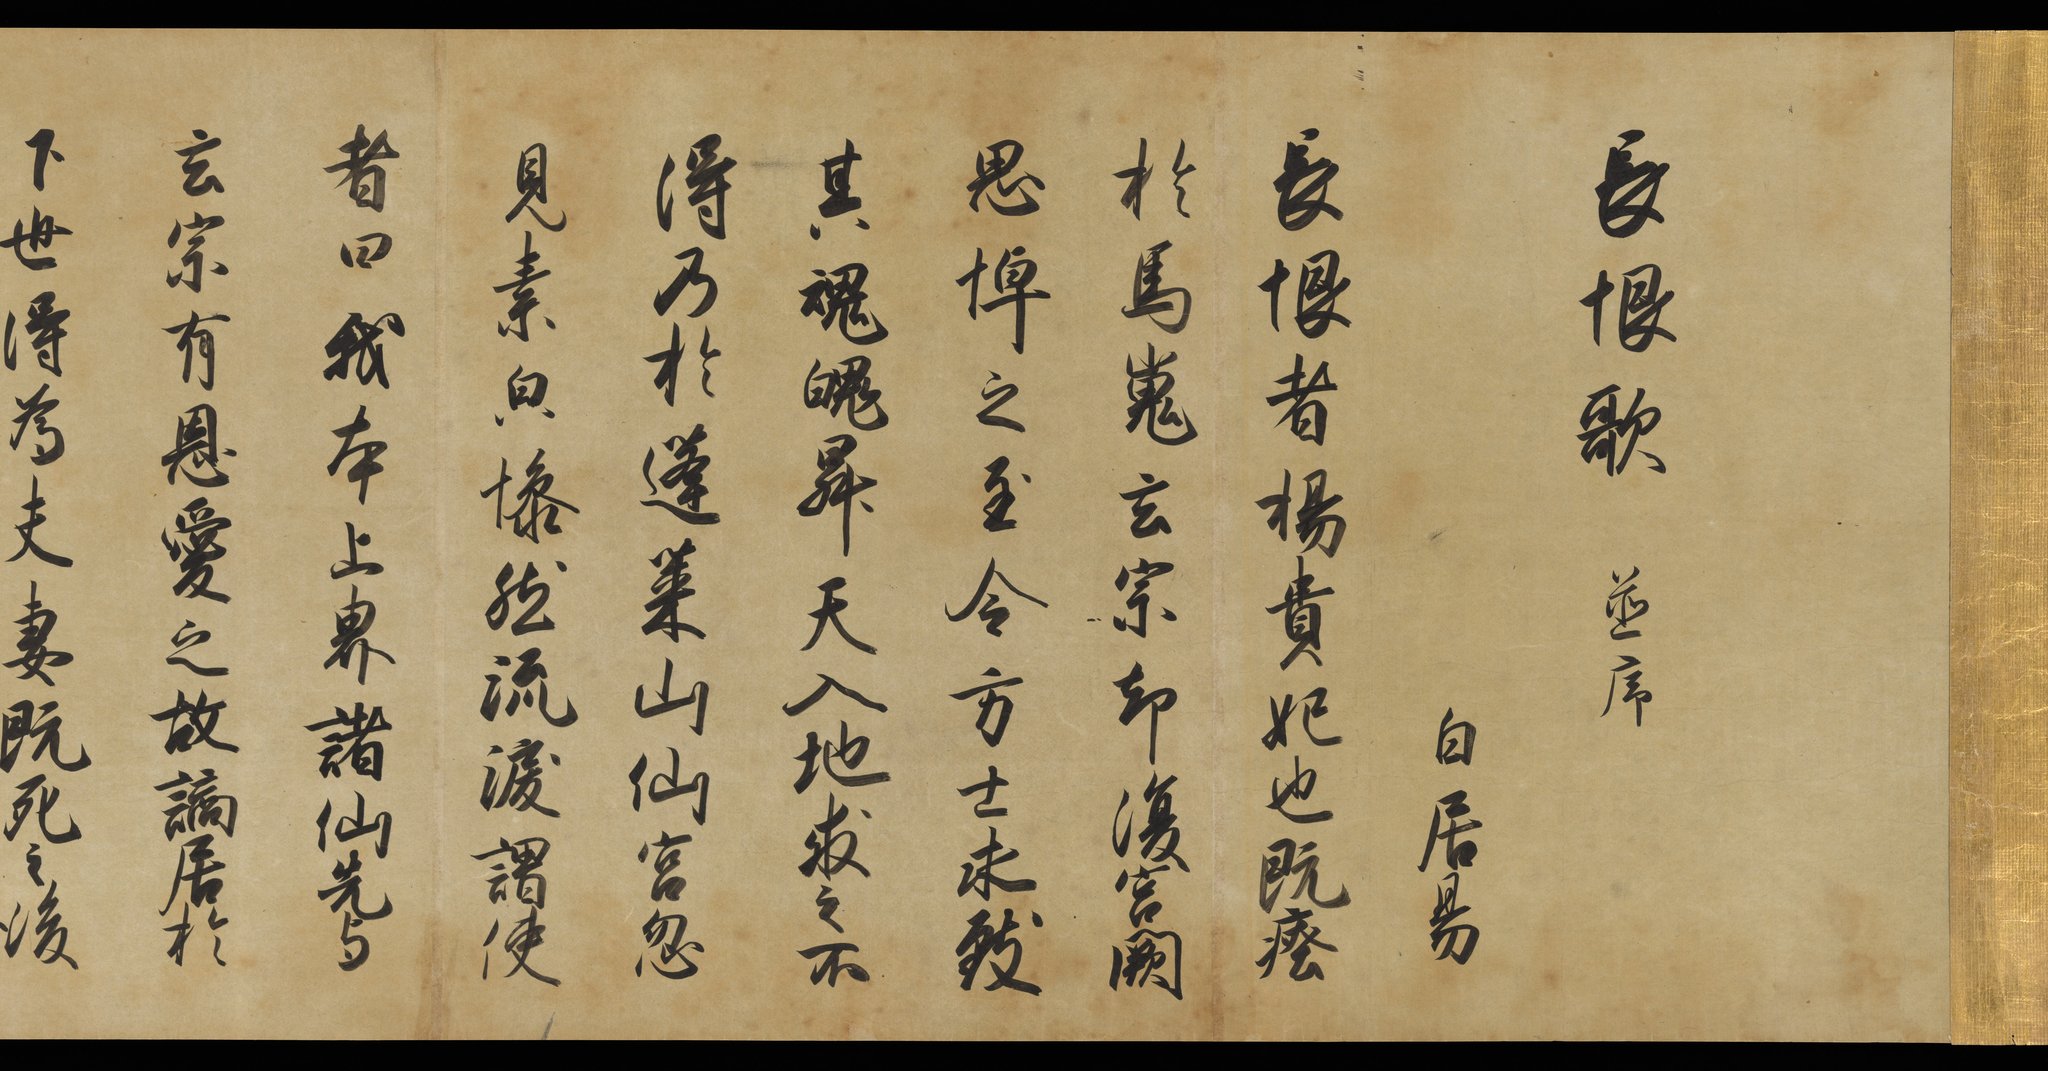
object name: handscroll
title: Freehand copy of a transcription of “The Song of Everlasting Sorrow” by Bai Juyi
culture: japanese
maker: shōkadō shōjō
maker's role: artist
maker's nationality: japanese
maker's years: 1584-1639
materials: ink, paper